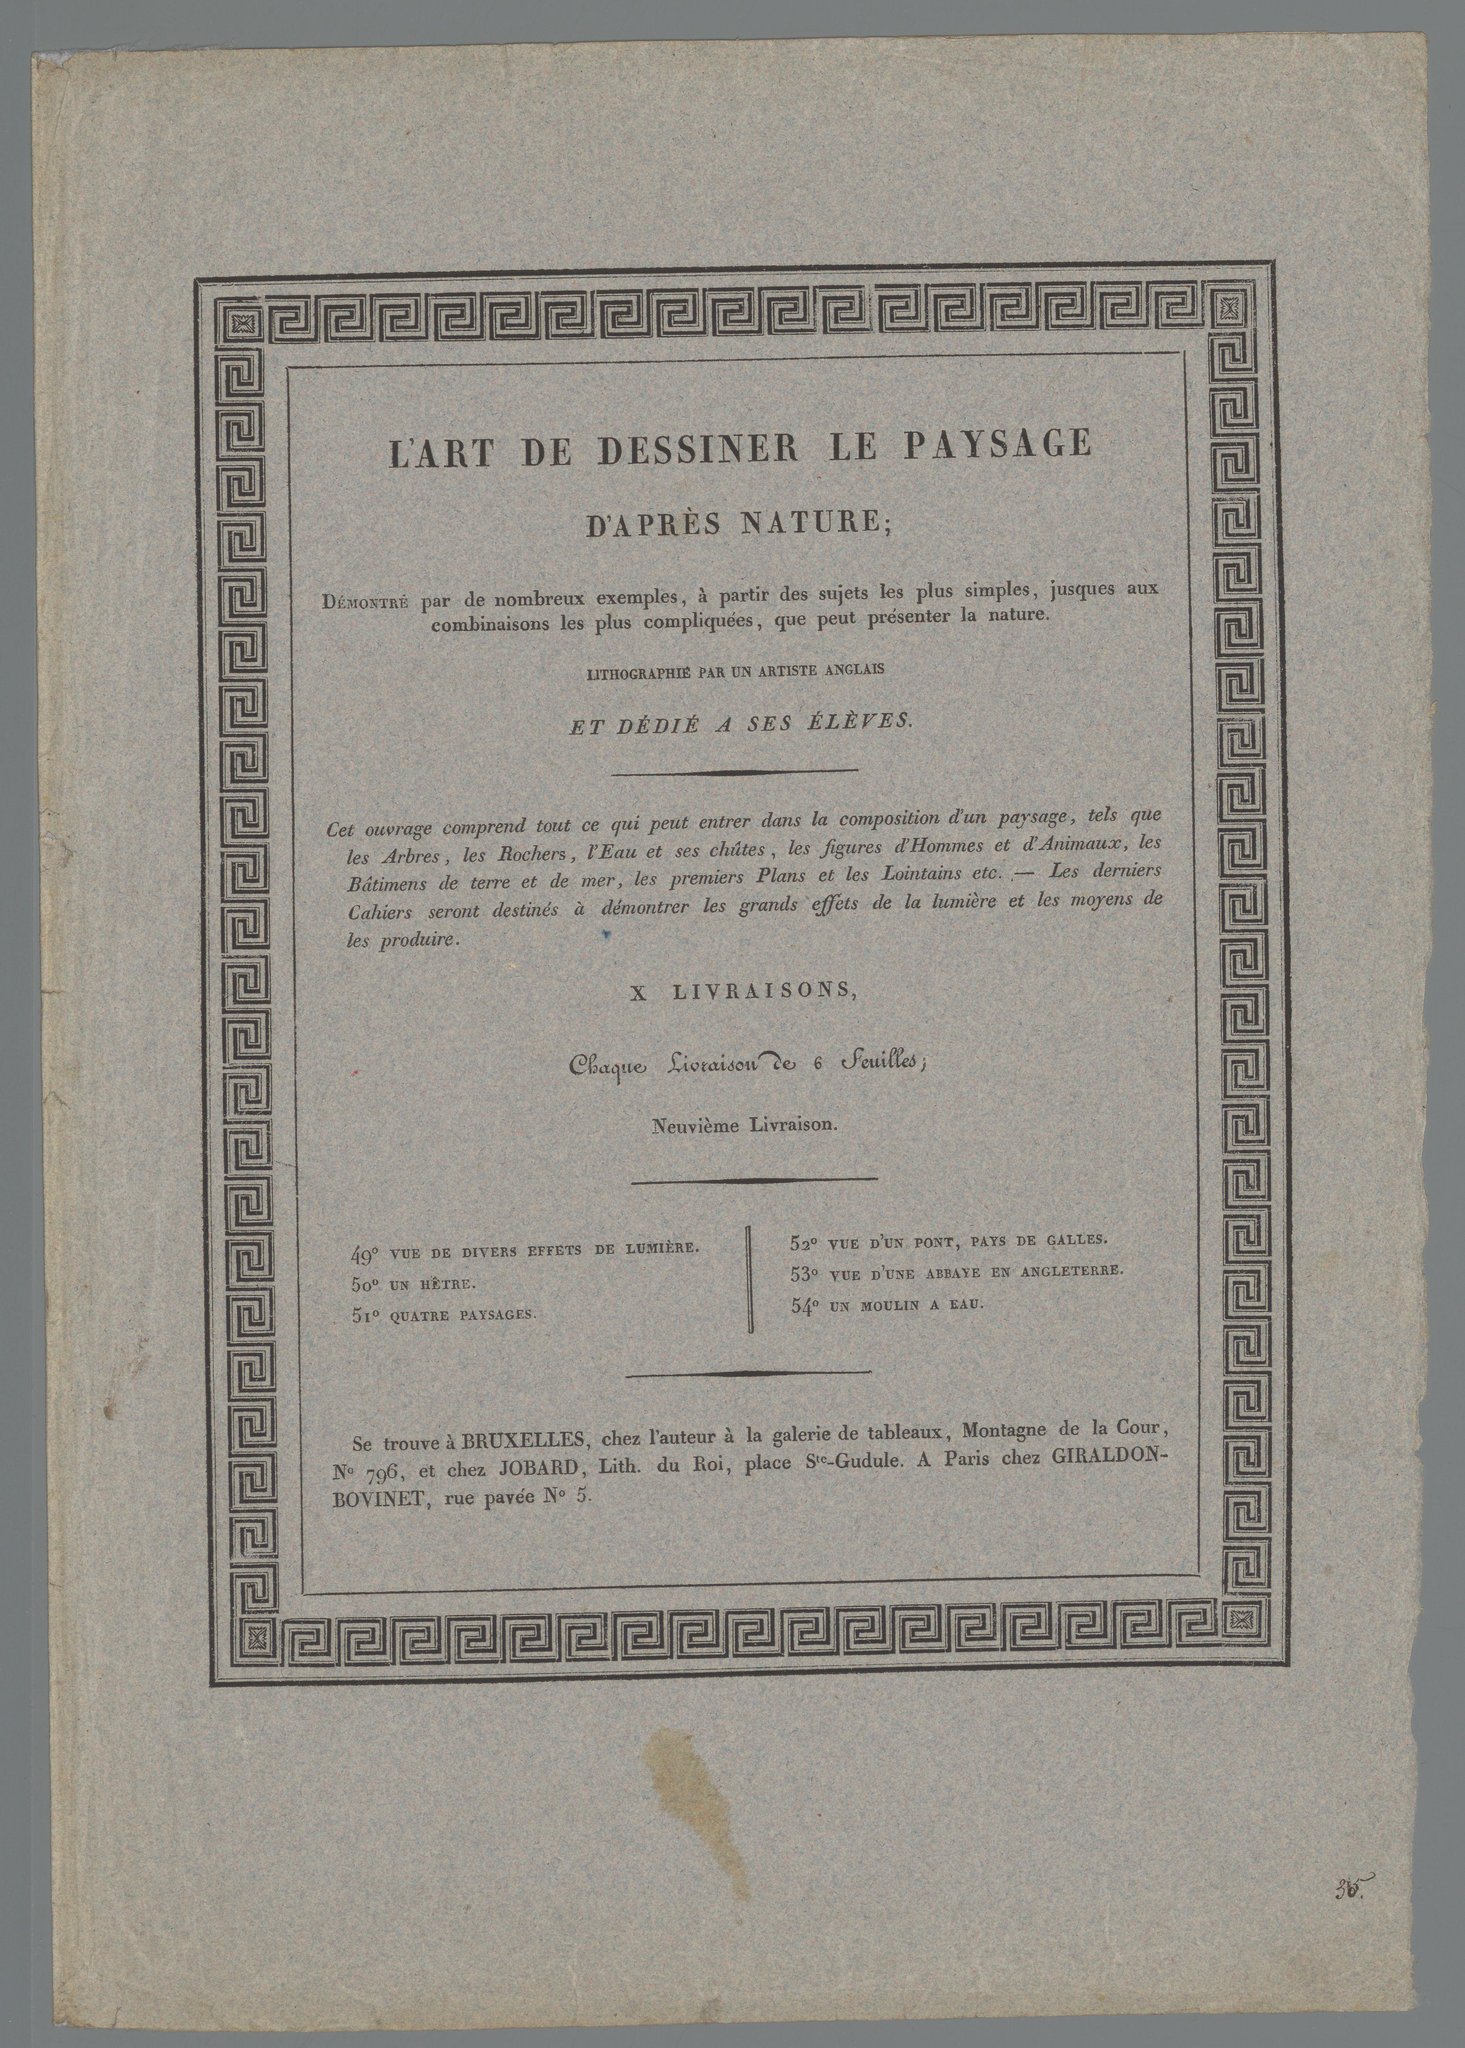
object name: wrapper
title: Landschapsstudies door Richard Sasse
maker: richard sasse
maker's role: print maker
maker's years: 1774-1849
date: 1800-1849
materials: paper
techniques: lithograph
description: Omslag voor het negende deel van de serie 'L'art de dessiner le paysage d'apres nature'. Deze serie is in tien delen met elk zes lithografieën uitgegeven. In deze omslag zitten minder lithografieën dan vermeld op de omslag zelf en een deel van de lithografieën in de omslag behoort niet tot de genoemde levering van de serie.